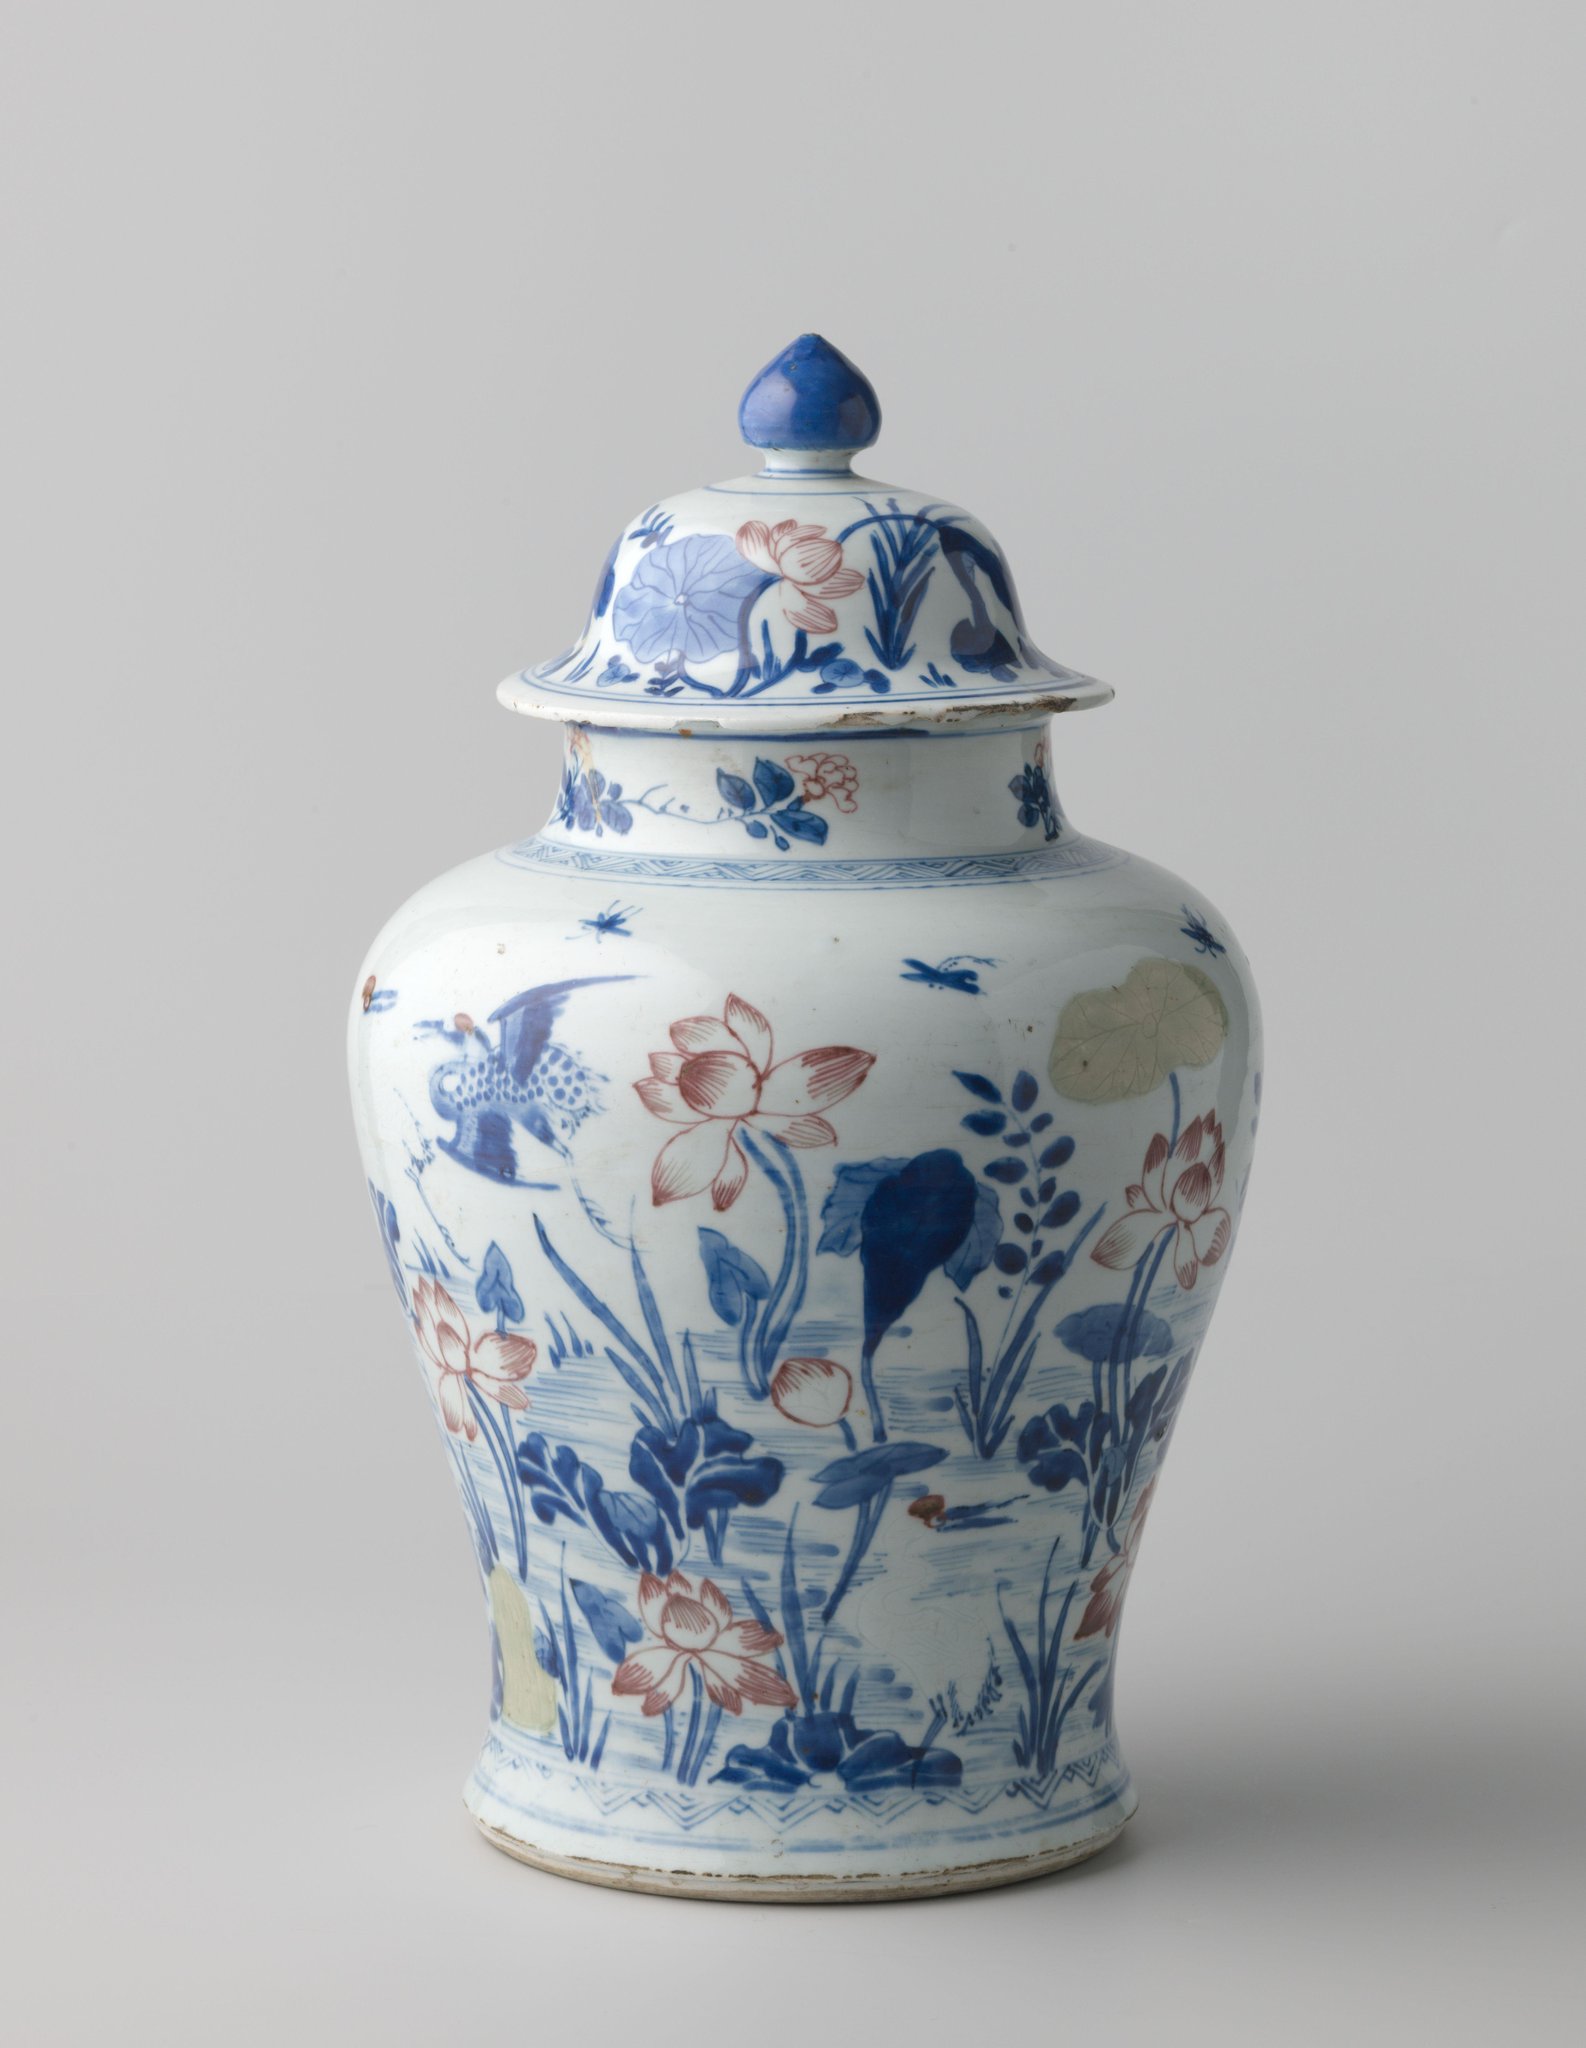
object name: covered jar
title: Baluster covered jar with lotus plants and cranes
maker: Anonymous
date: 1700-1724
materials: cobalt, copper, glaze, paint, porcelain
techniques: firing, turning, vitrification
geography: china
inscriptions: mark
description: Balustervormige dekselpot van porselein met een spreidende voet en een brede hals. Beschilderd in onderglazuur blauw en rood en een wit slib. Op de wand een doorlopende voorstelling van een vijver met lotusplanten en staande en vliegende kraanvogels. Rond de voet en op de schouder een decoratieve band. De hals met bloemtakken. Op de deksel lotusplanten. Gemerkt op de onderzijde met een artemisiablad in een dubbele cirkel. Een barst in de hals van de pot. Twee scherven uit de deksel. Onderglazuur blauw met koperrood.